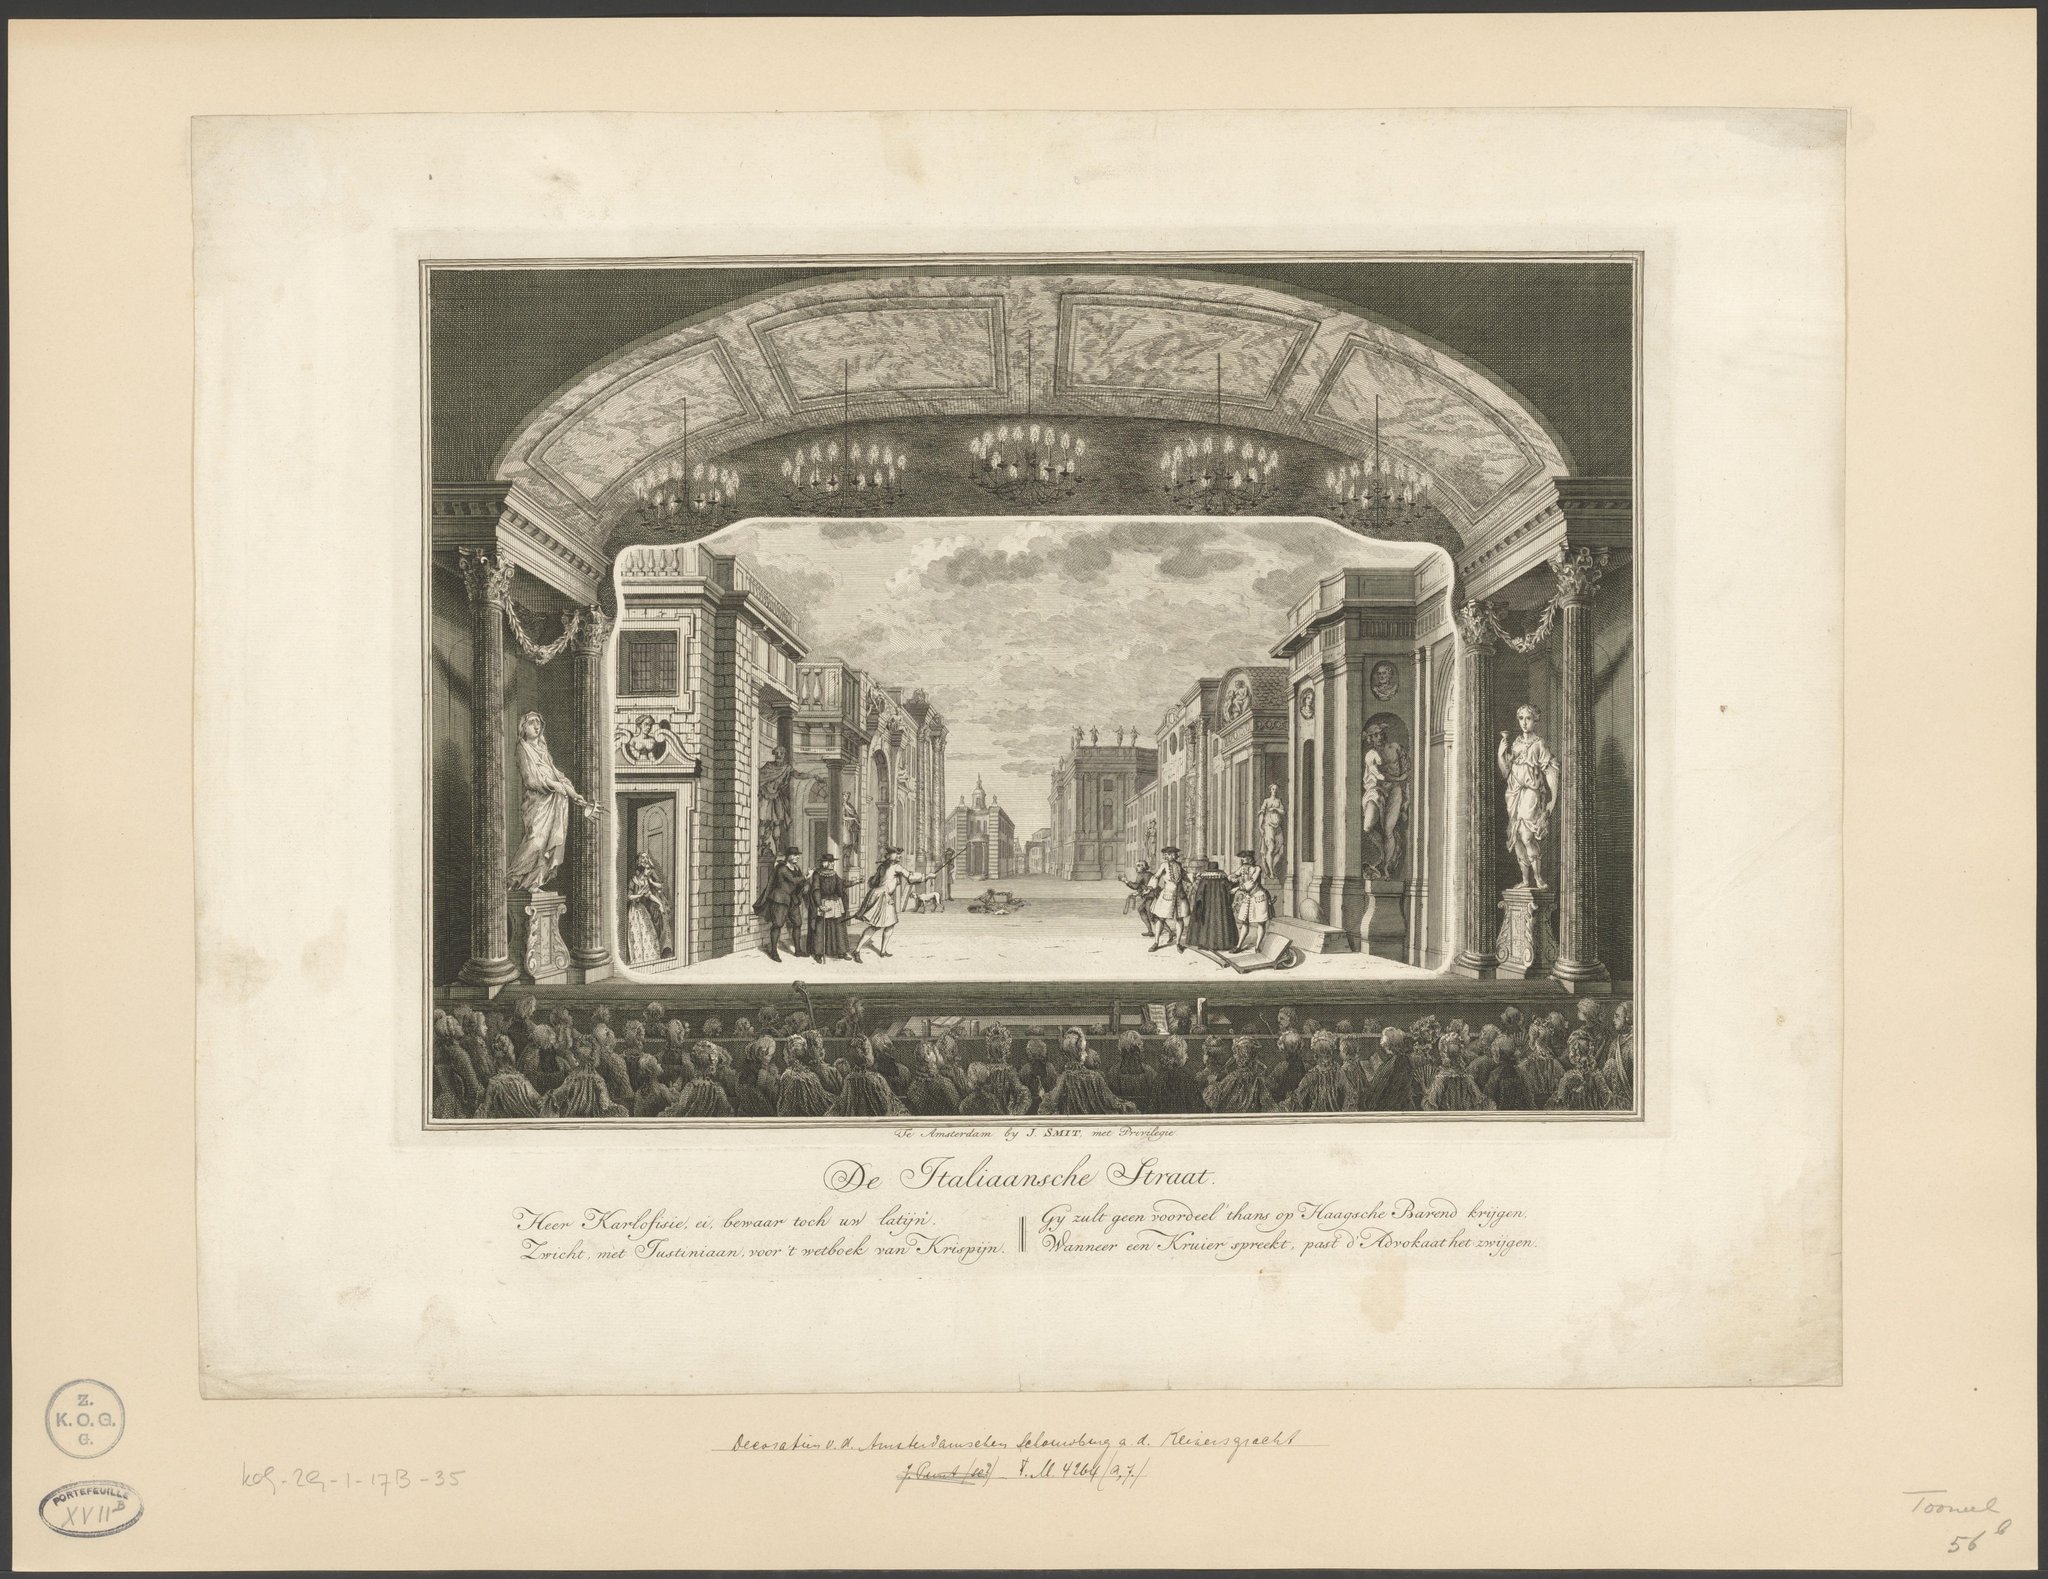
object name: print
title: Schouwburg met toneeldecor: De Italiaansche Straat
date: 1736-1738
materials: paper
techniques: engraving, etching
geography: amsterdam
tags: theatre, theatrical performance, stage design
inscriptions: stamp, collector's mark: Lugt 1641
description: Toneelvoorstelling in de Amsterdamse Schouwburg op de Keizersgracht met het coulissendecor De Italiaansche Straat met scène uit: De Gewaande Advocaat. Het decor gedrukt van een aparte plaat binnen een nieuw passe-partout met de zaal, orkestbak en de façade van het toneel met zuilen en kroonluchters. De titel en een vierregelig vers ook gedrukt van een aparte plaat. Onderdeel van een latere uitgave van de serie van twaalf toneeldecors. Onderwerpsrubrieken binnen de Atlas Zeden en Gewoonten: Schoone kunsten, Tooneel, Schouwburg op de Keizersgracht (1637 – 1772).